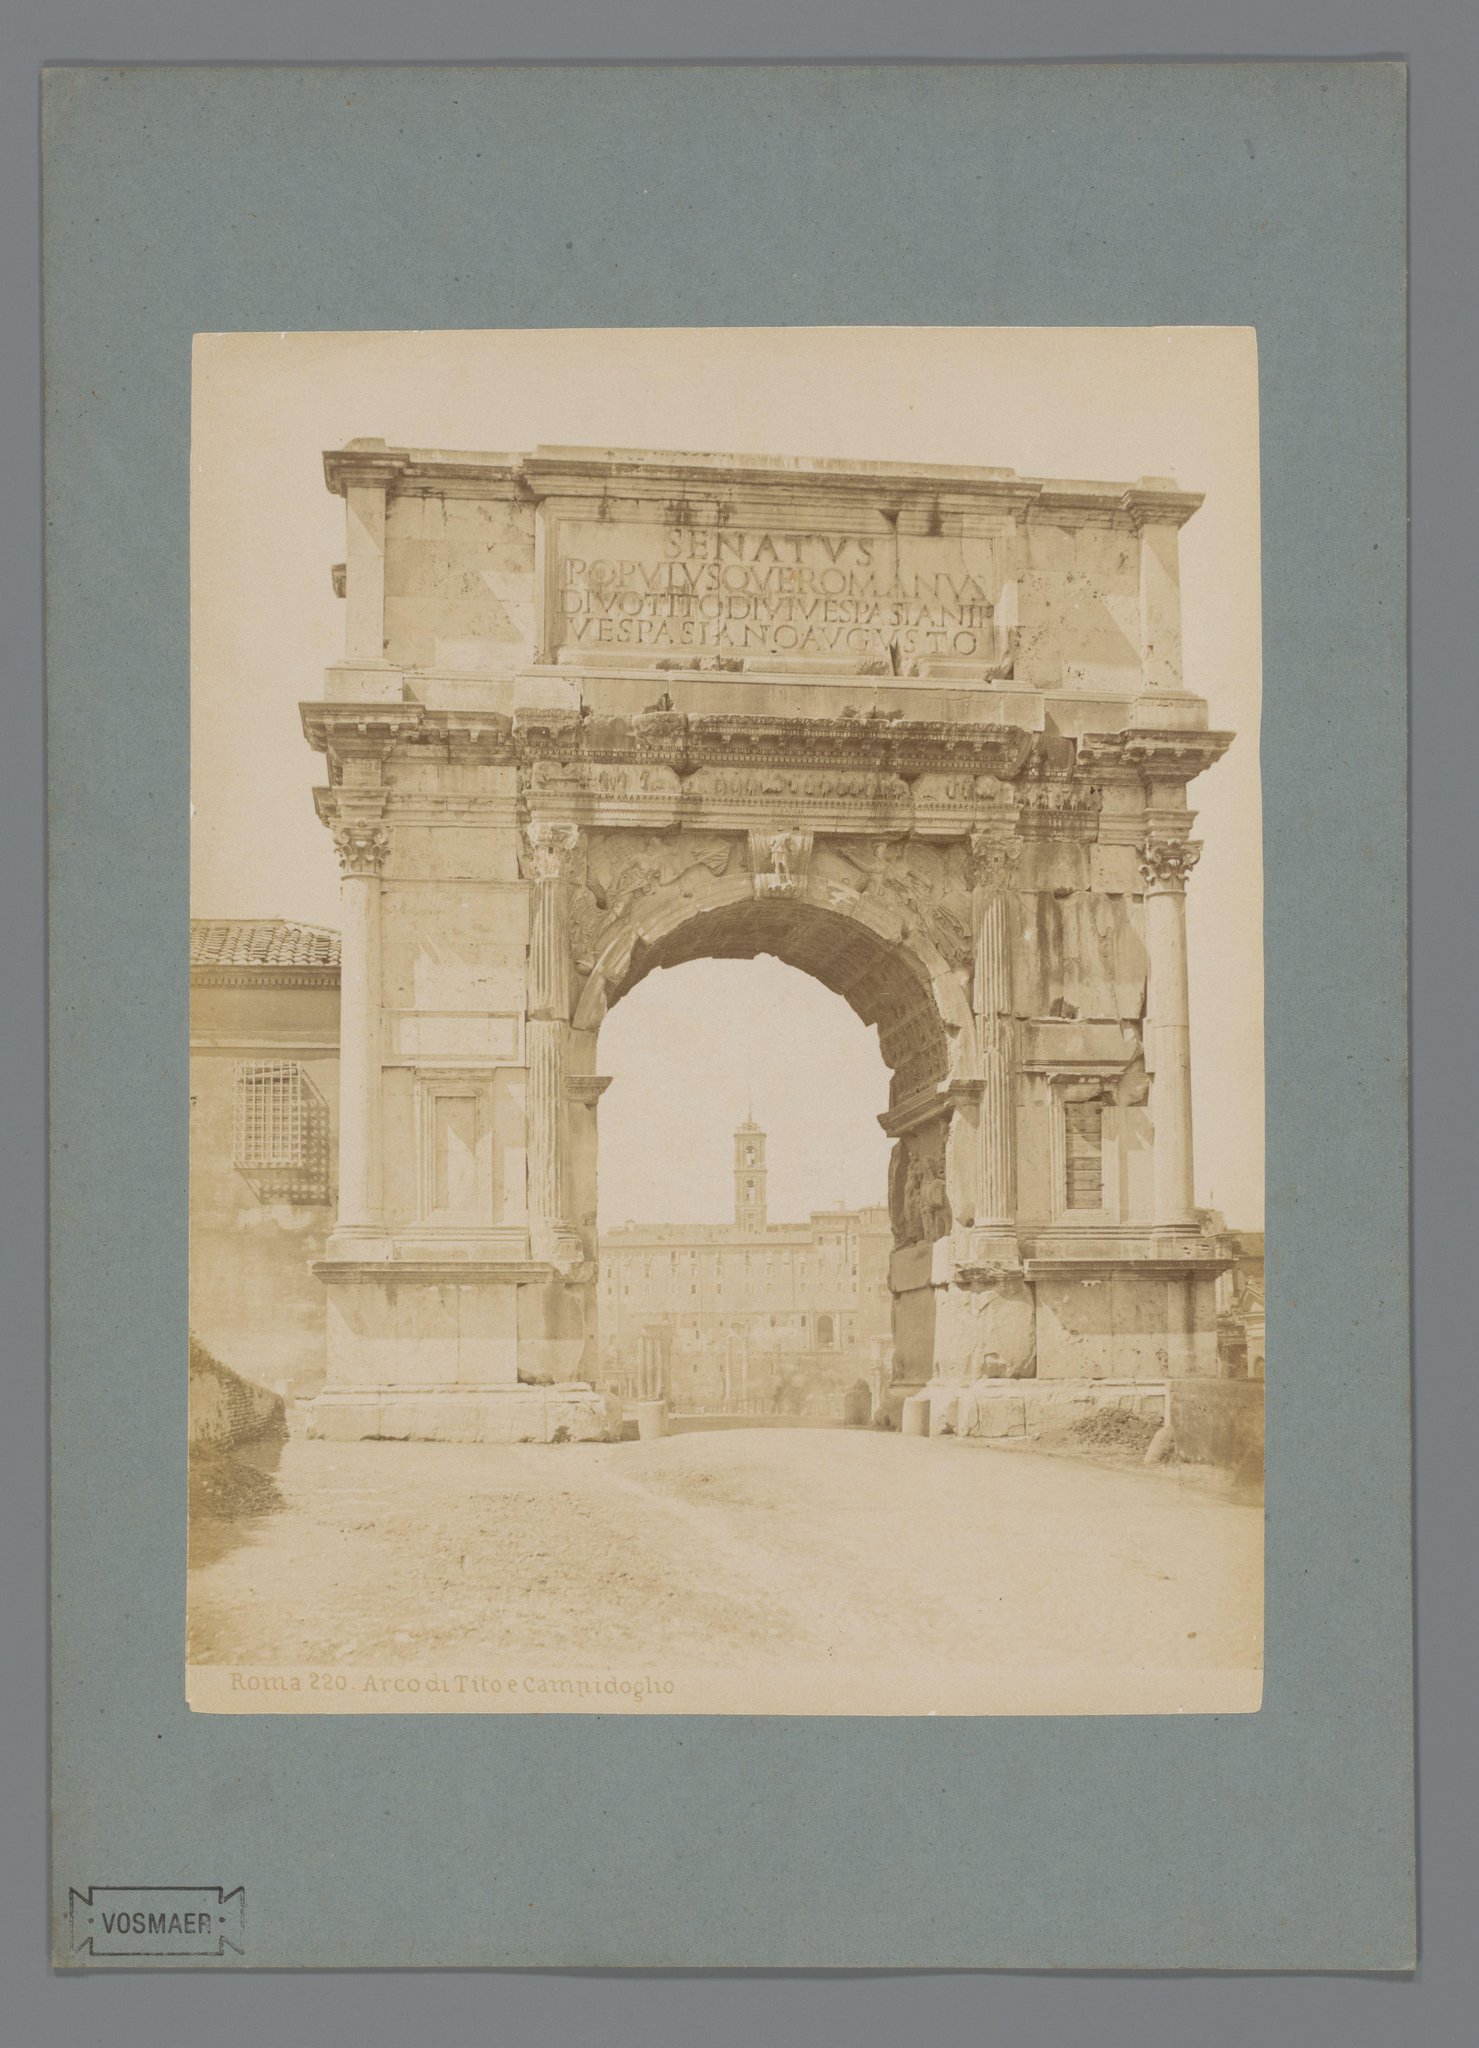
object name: photograph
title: Gezicht op de Boog van Titus op het Forum Romanum in Rome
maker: Anonymous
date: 1851-1900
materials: cardboard, paper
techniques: albumen print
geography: forum romanum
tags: triumphal arch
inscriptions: collector's mark: ‘VOSMAER’, number: ‘220.’